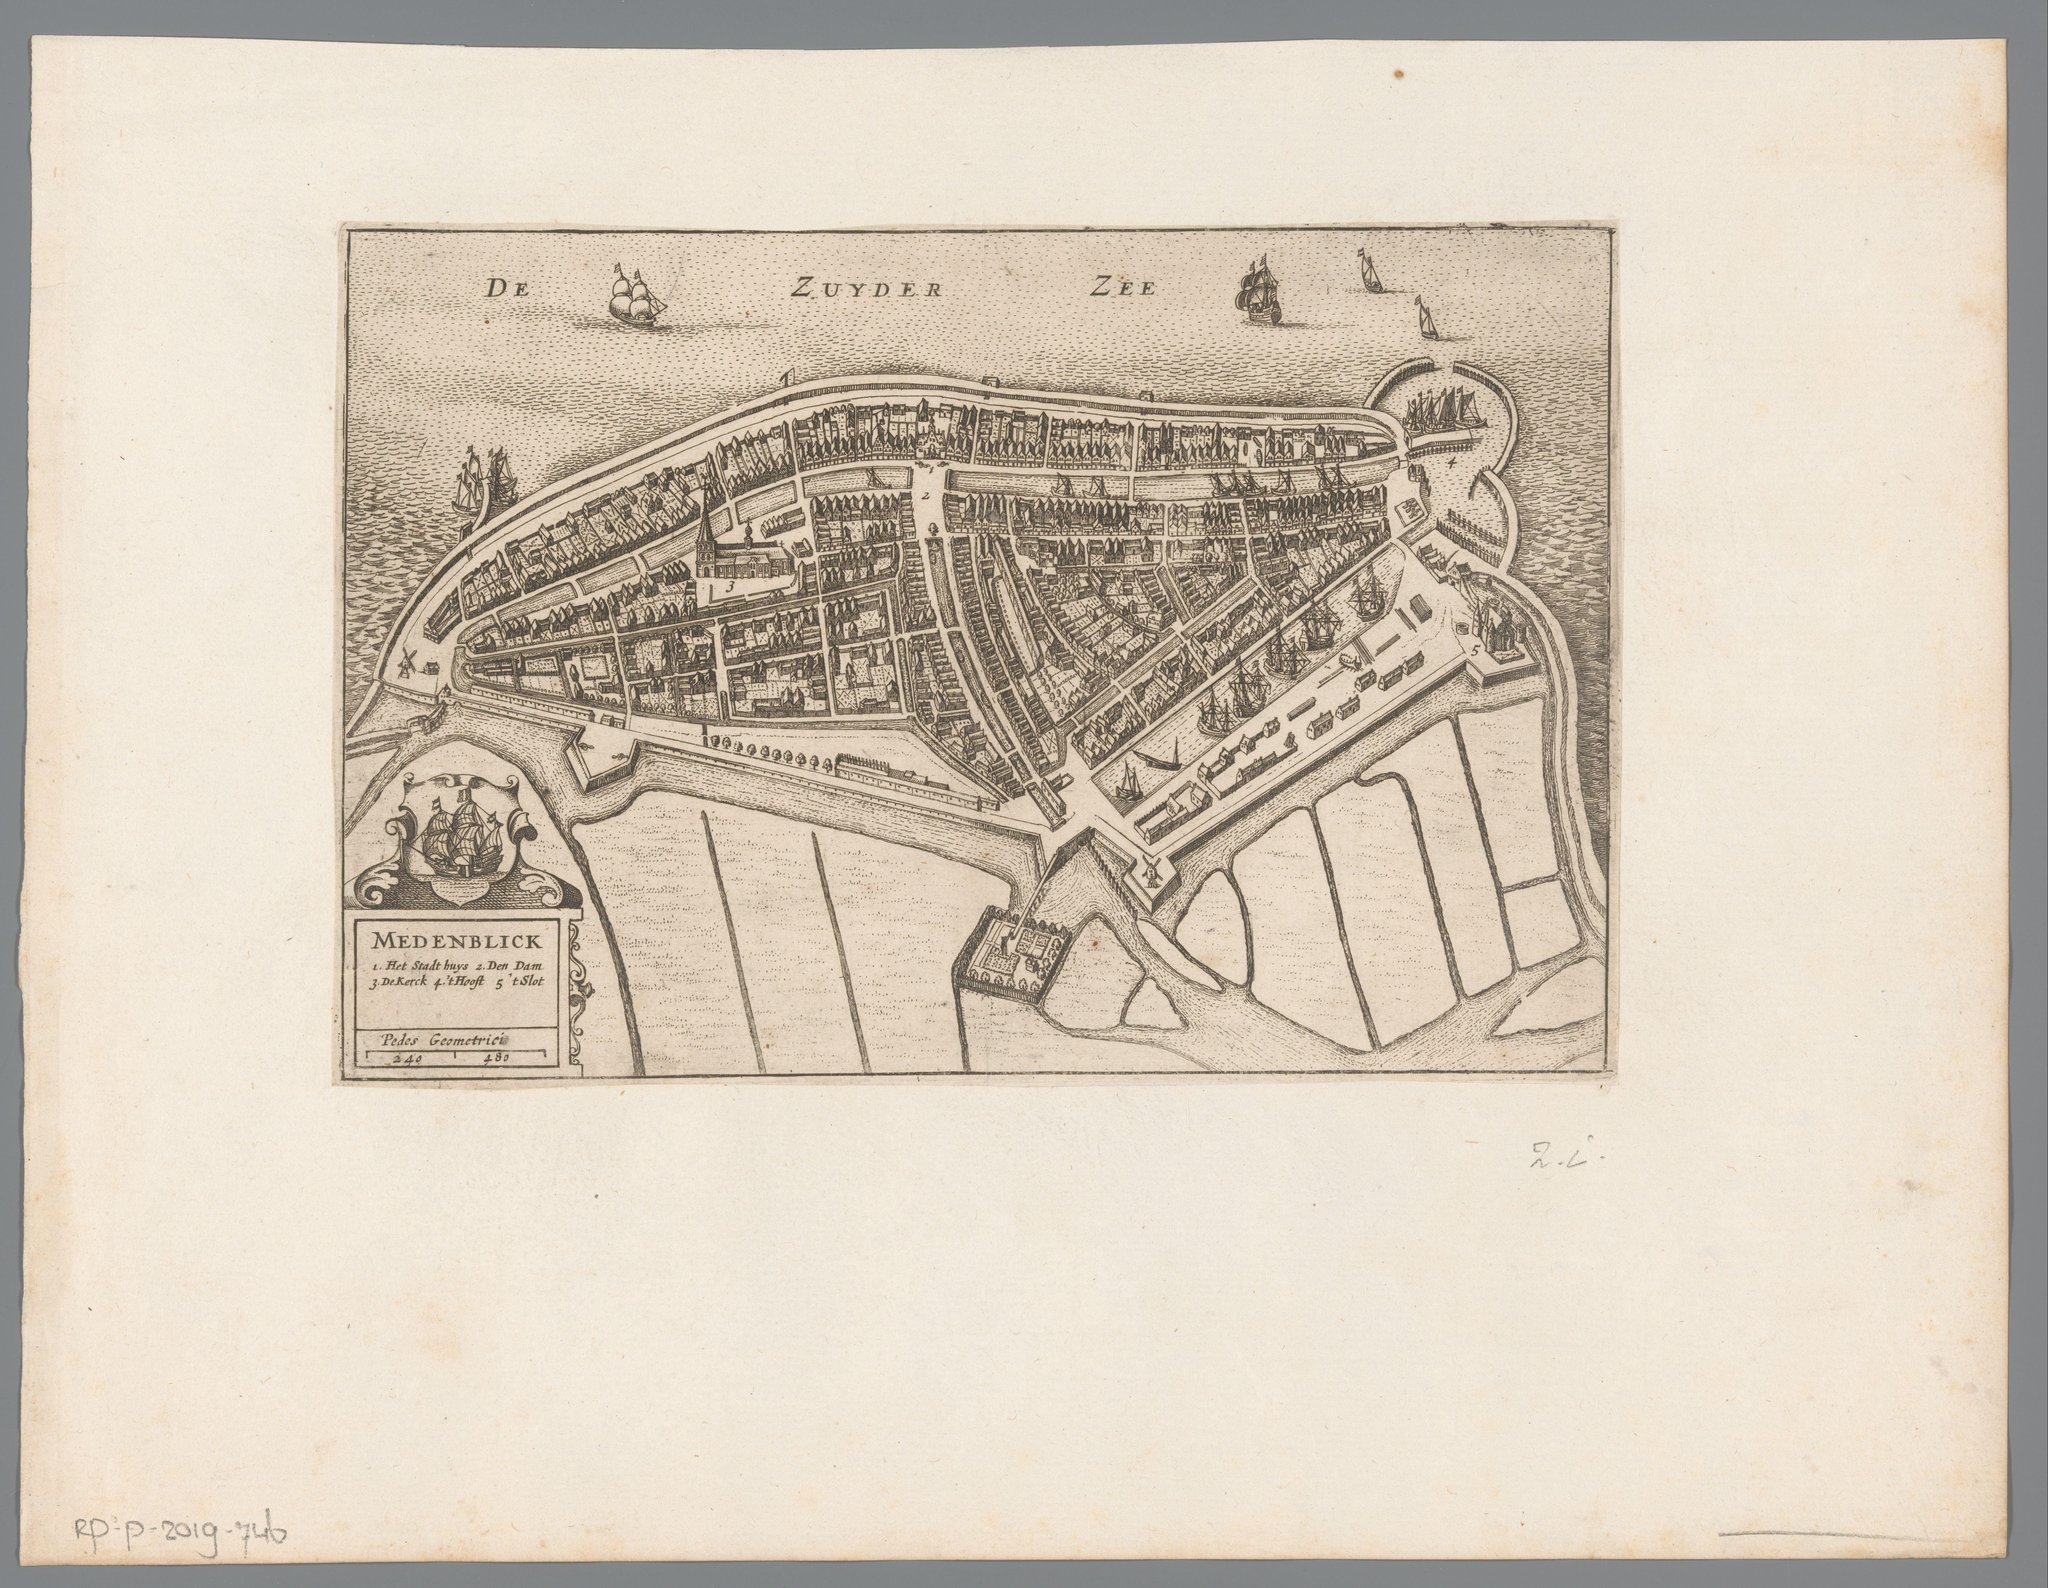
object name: area plan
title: Plattegrond van Medemblik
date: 1632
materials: paper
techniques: etching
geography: amsterdam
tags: maps of cities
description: Prent uit: Boxhorn, Marcus Zuerius. Theatrum sive Hollandiae comitatus et urbium nova descriptio (...). Amsterdam: Henricus Hondius, 1632, p. 381. Later ook gebruikt in: Boxhorn, Marcus Zuerius. Toneel ofte beschryvinge der steden van Hollandt (...). Amsterdam: Jacob Keyns, [1634], p. 372. Later ook nog uitgegeven in: Novum ac magnum theatrum urbium Belgicae. 2 dln. Amsterdam: Joan Blaeu, [1649], eerste en tweede editie.